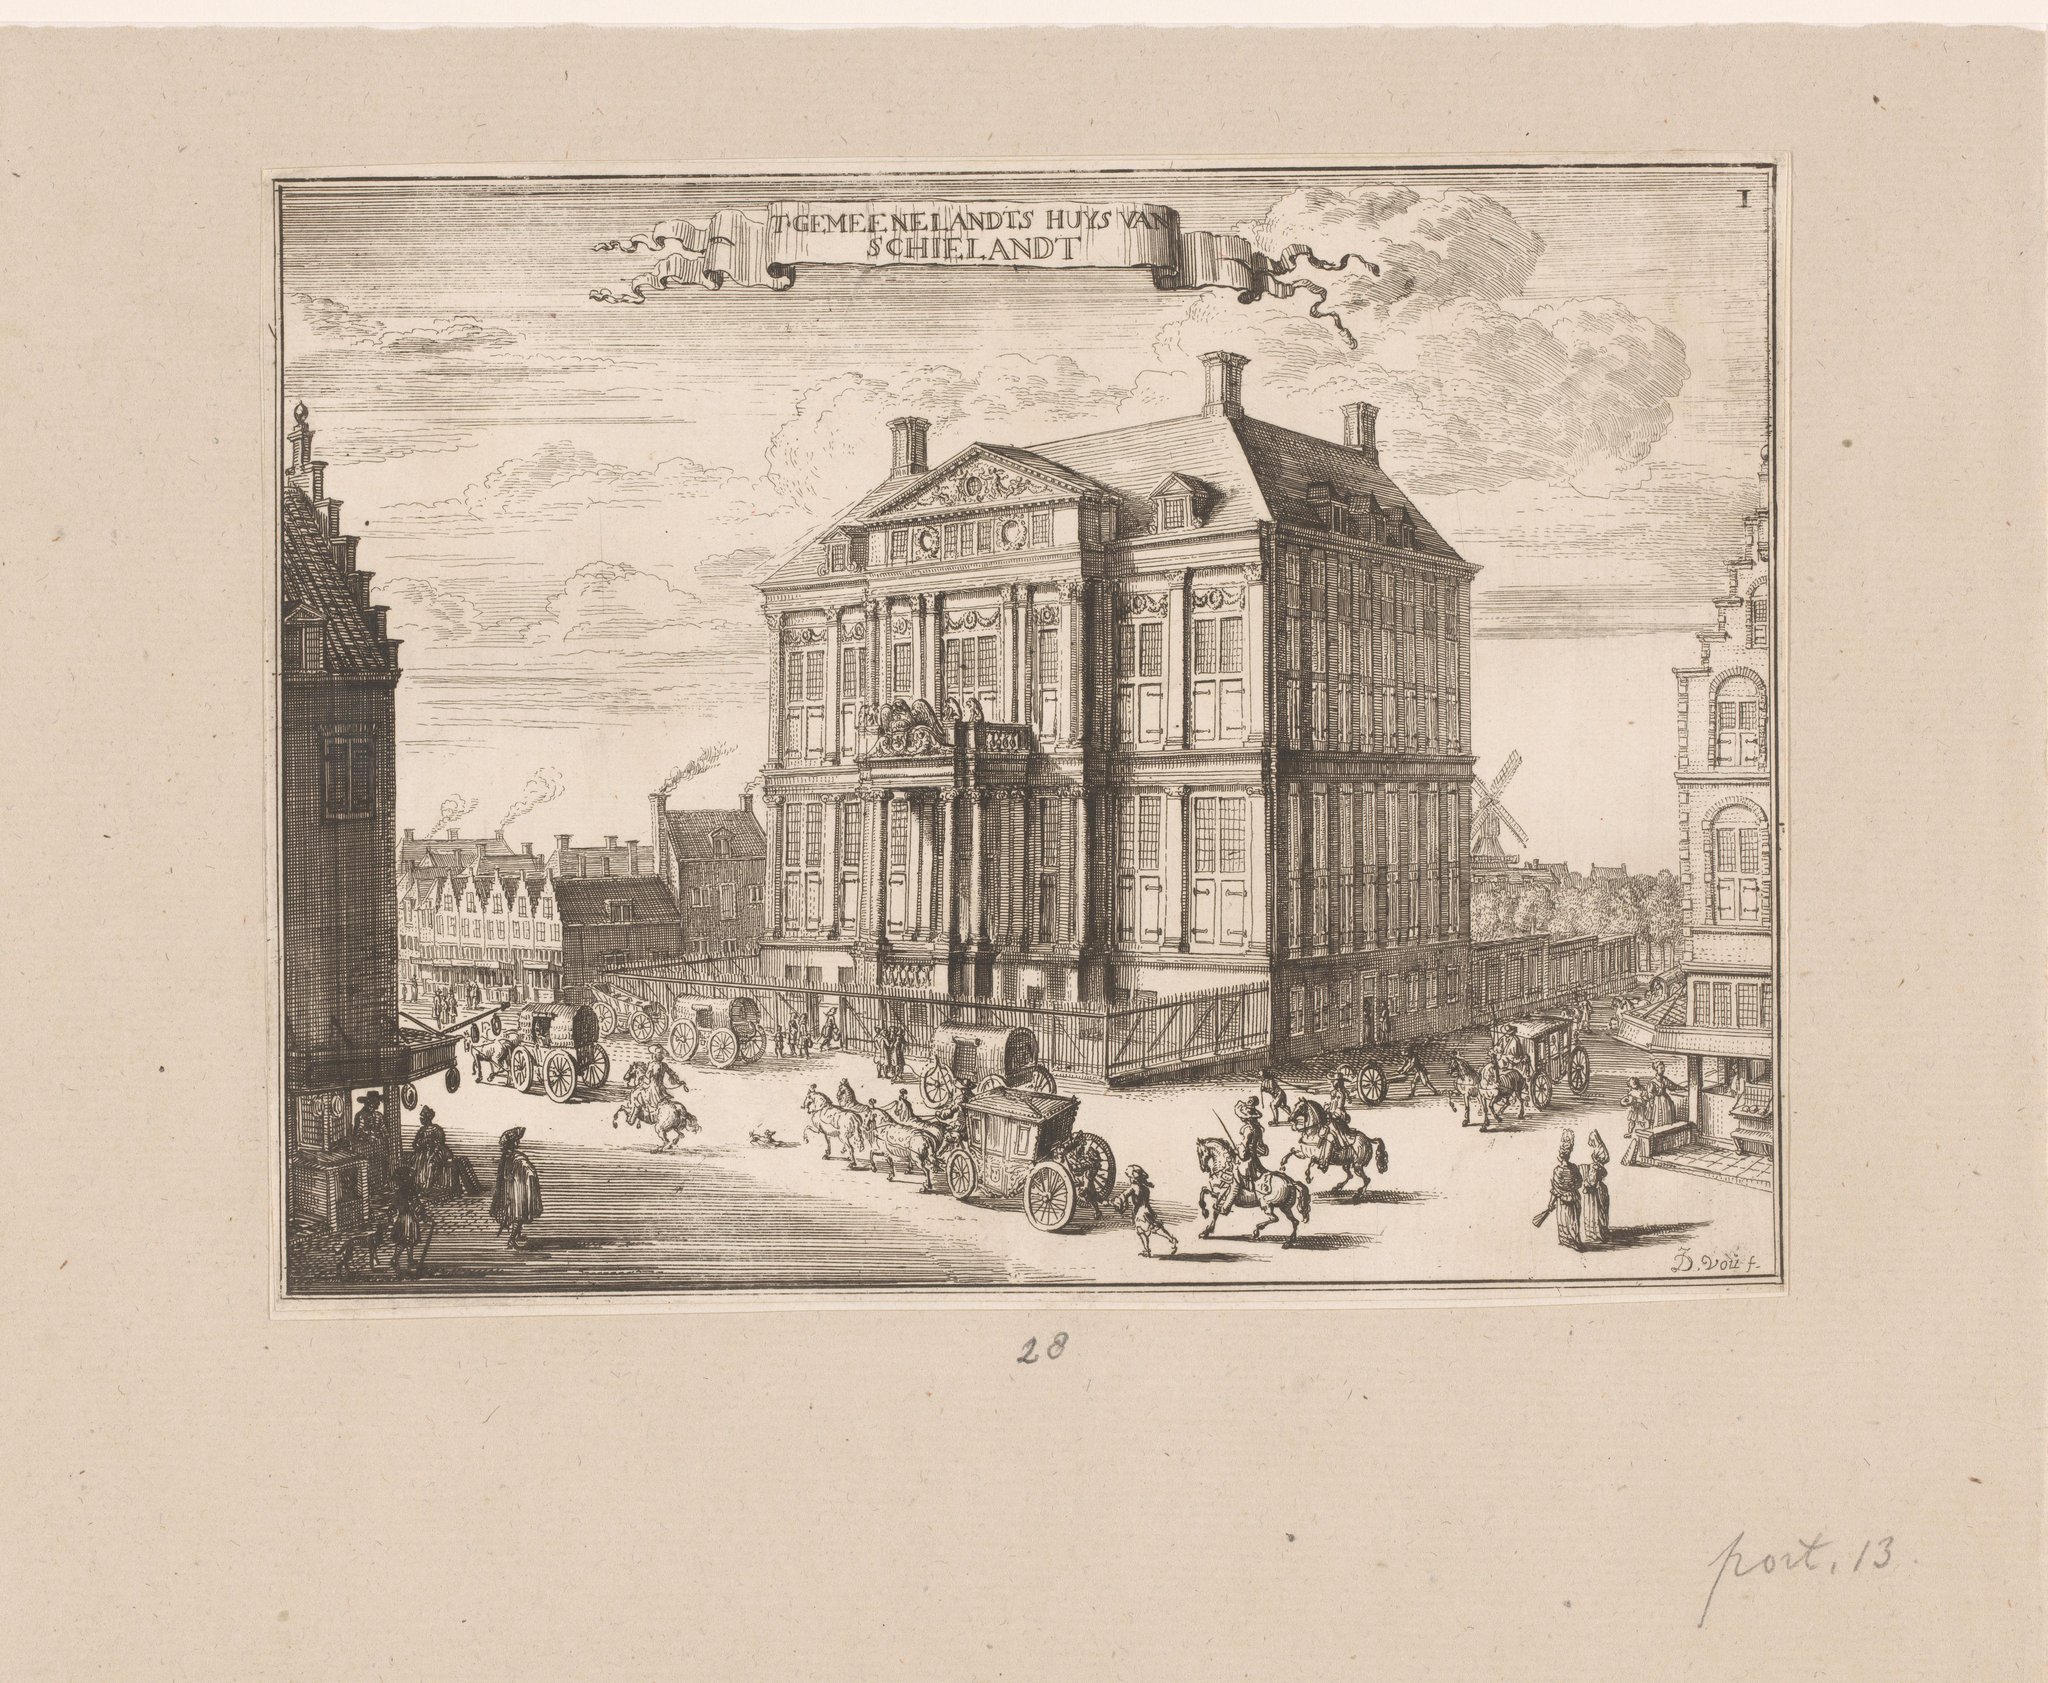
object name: print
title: T' Gemeenelandts Huys van Schielandt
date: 1694-1695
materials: paper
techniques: etching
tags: exterior ~ representation of a building, street (+ city(-scape) with figures, staffage)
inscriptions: collector's mark: Lugt 195, collector's mark: Lugt 2228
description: Prent oorspronkelijk gedrukt als onderdeel van de sierrand van 'Rotterdam met al syn gebouwen net op haer maet geteekent en gesneden', een wandkaart van Rotterdam, in prent gebracht door Romeyn de Hooghe en Johannes de Vouw. De rand om de plattegrond bestond uit wapenranden (langs de bovenkant en zijkanten), twaalf stadsgezichten (A-F langs de linker zijkant en G-M langs de rechter zijkant) en een stadsprofiel (langs de onderkant). Zie documentatie voor meer informatie. Zie ook RP-P-AO-13-87.